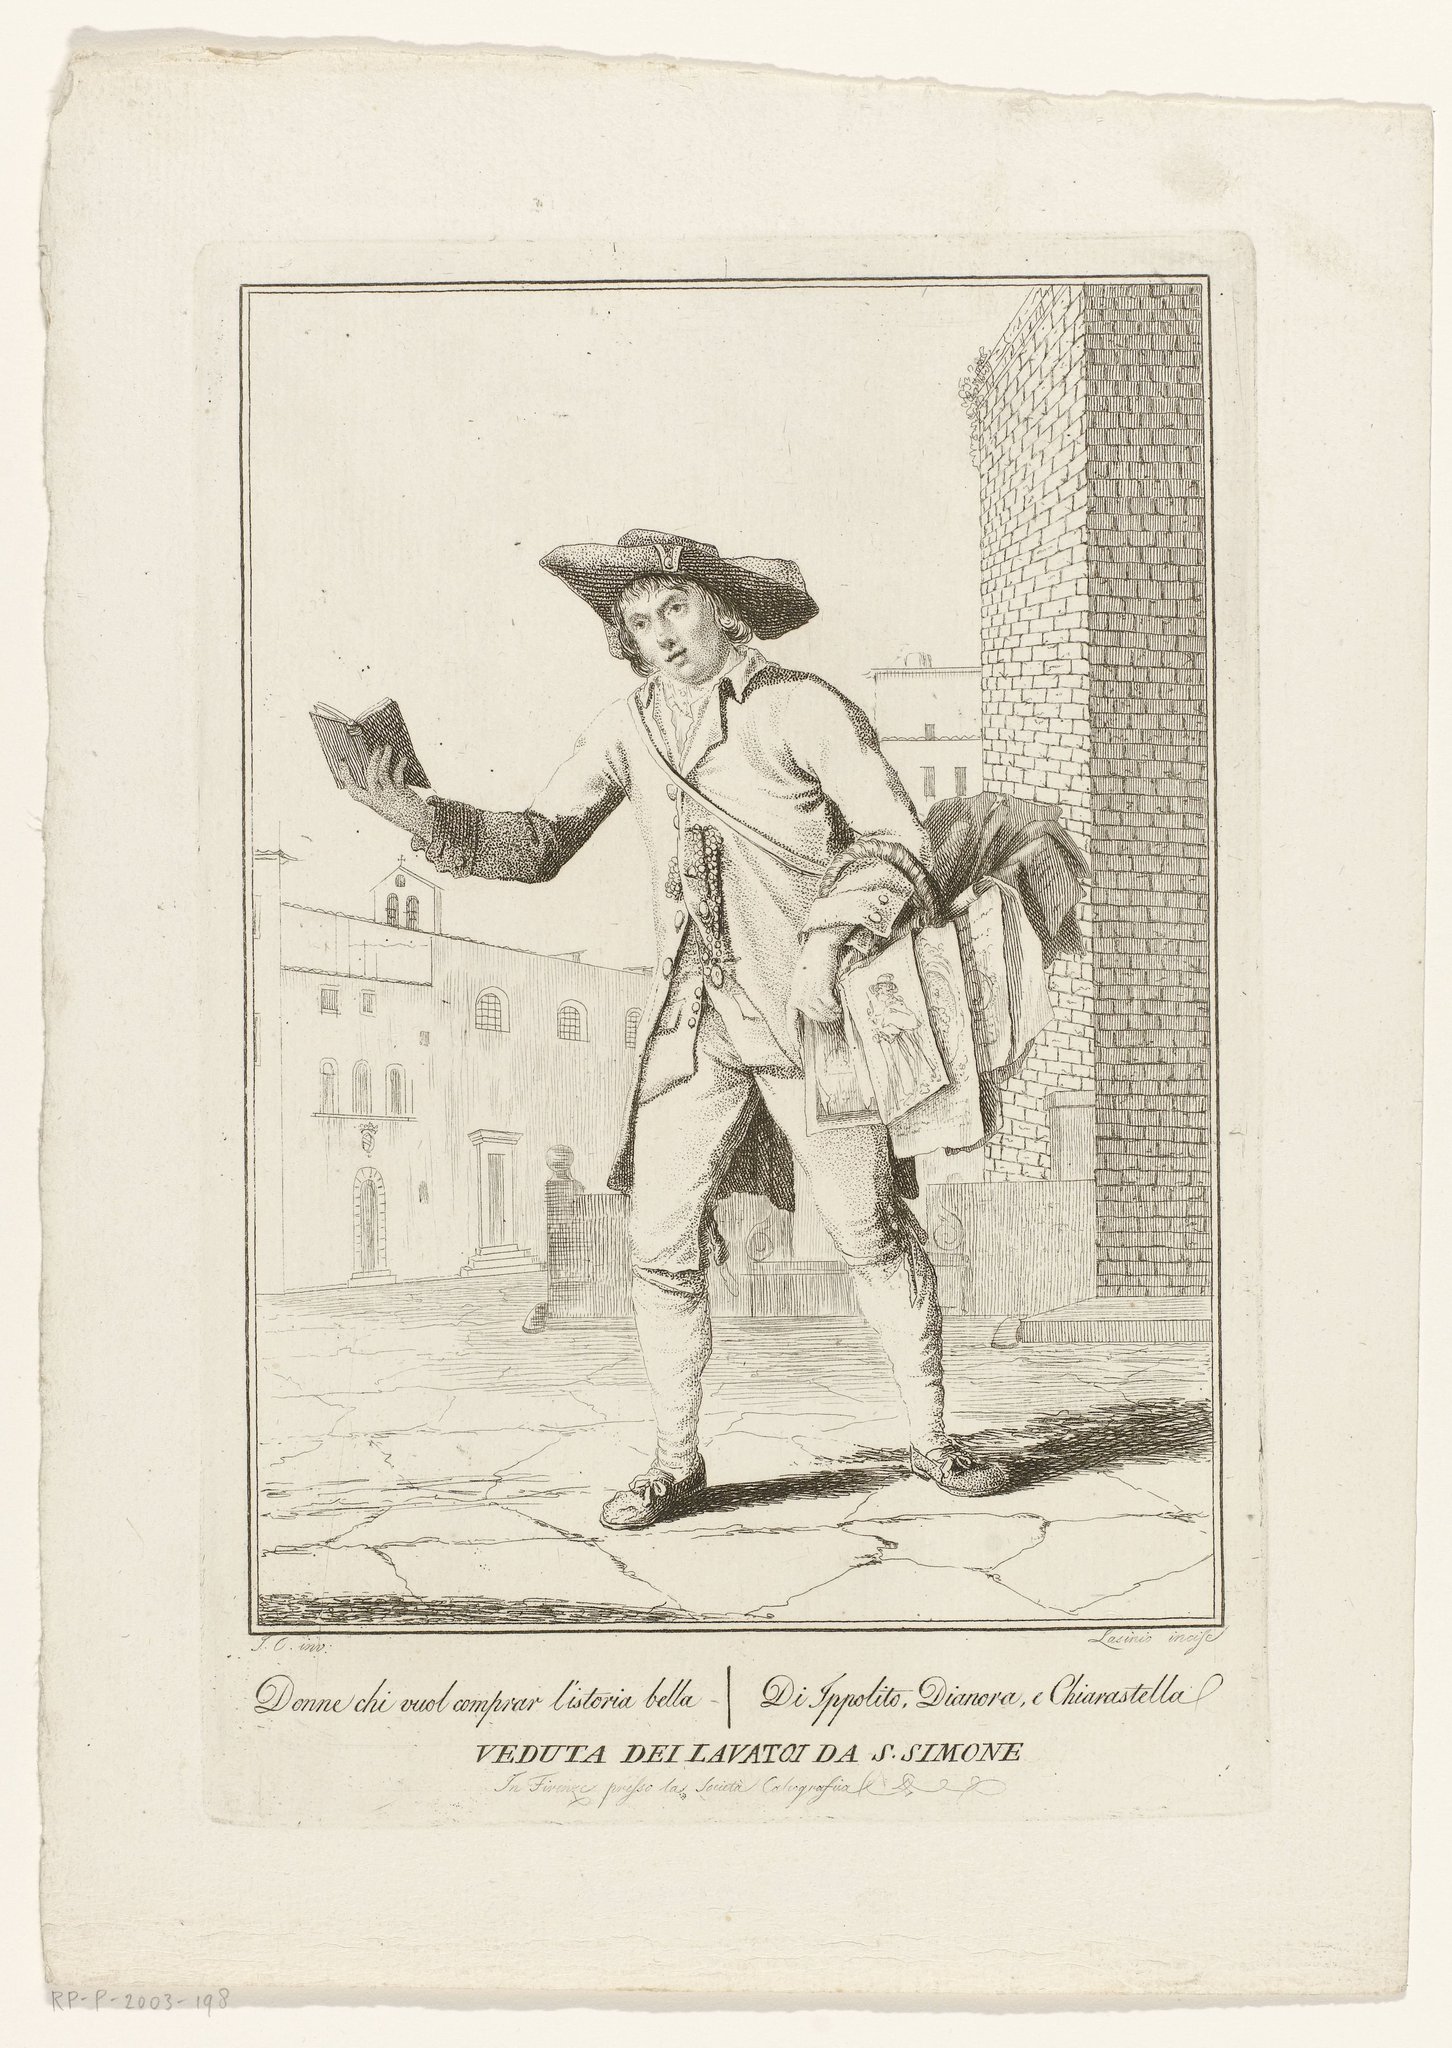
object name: print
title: Prentverkoper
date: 1769-1838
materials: paper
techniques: etching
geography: italy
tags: street-trader, merchant, salesman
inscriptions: collector's mark: Lugt 2228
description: Een verkoper van prenten en boeken op het Piazza San Simone in Florence. Aan zijn linkerarm een mand met prenten, in zijn rechterhand een boekje. Italiaanse tekst in ondermarge.